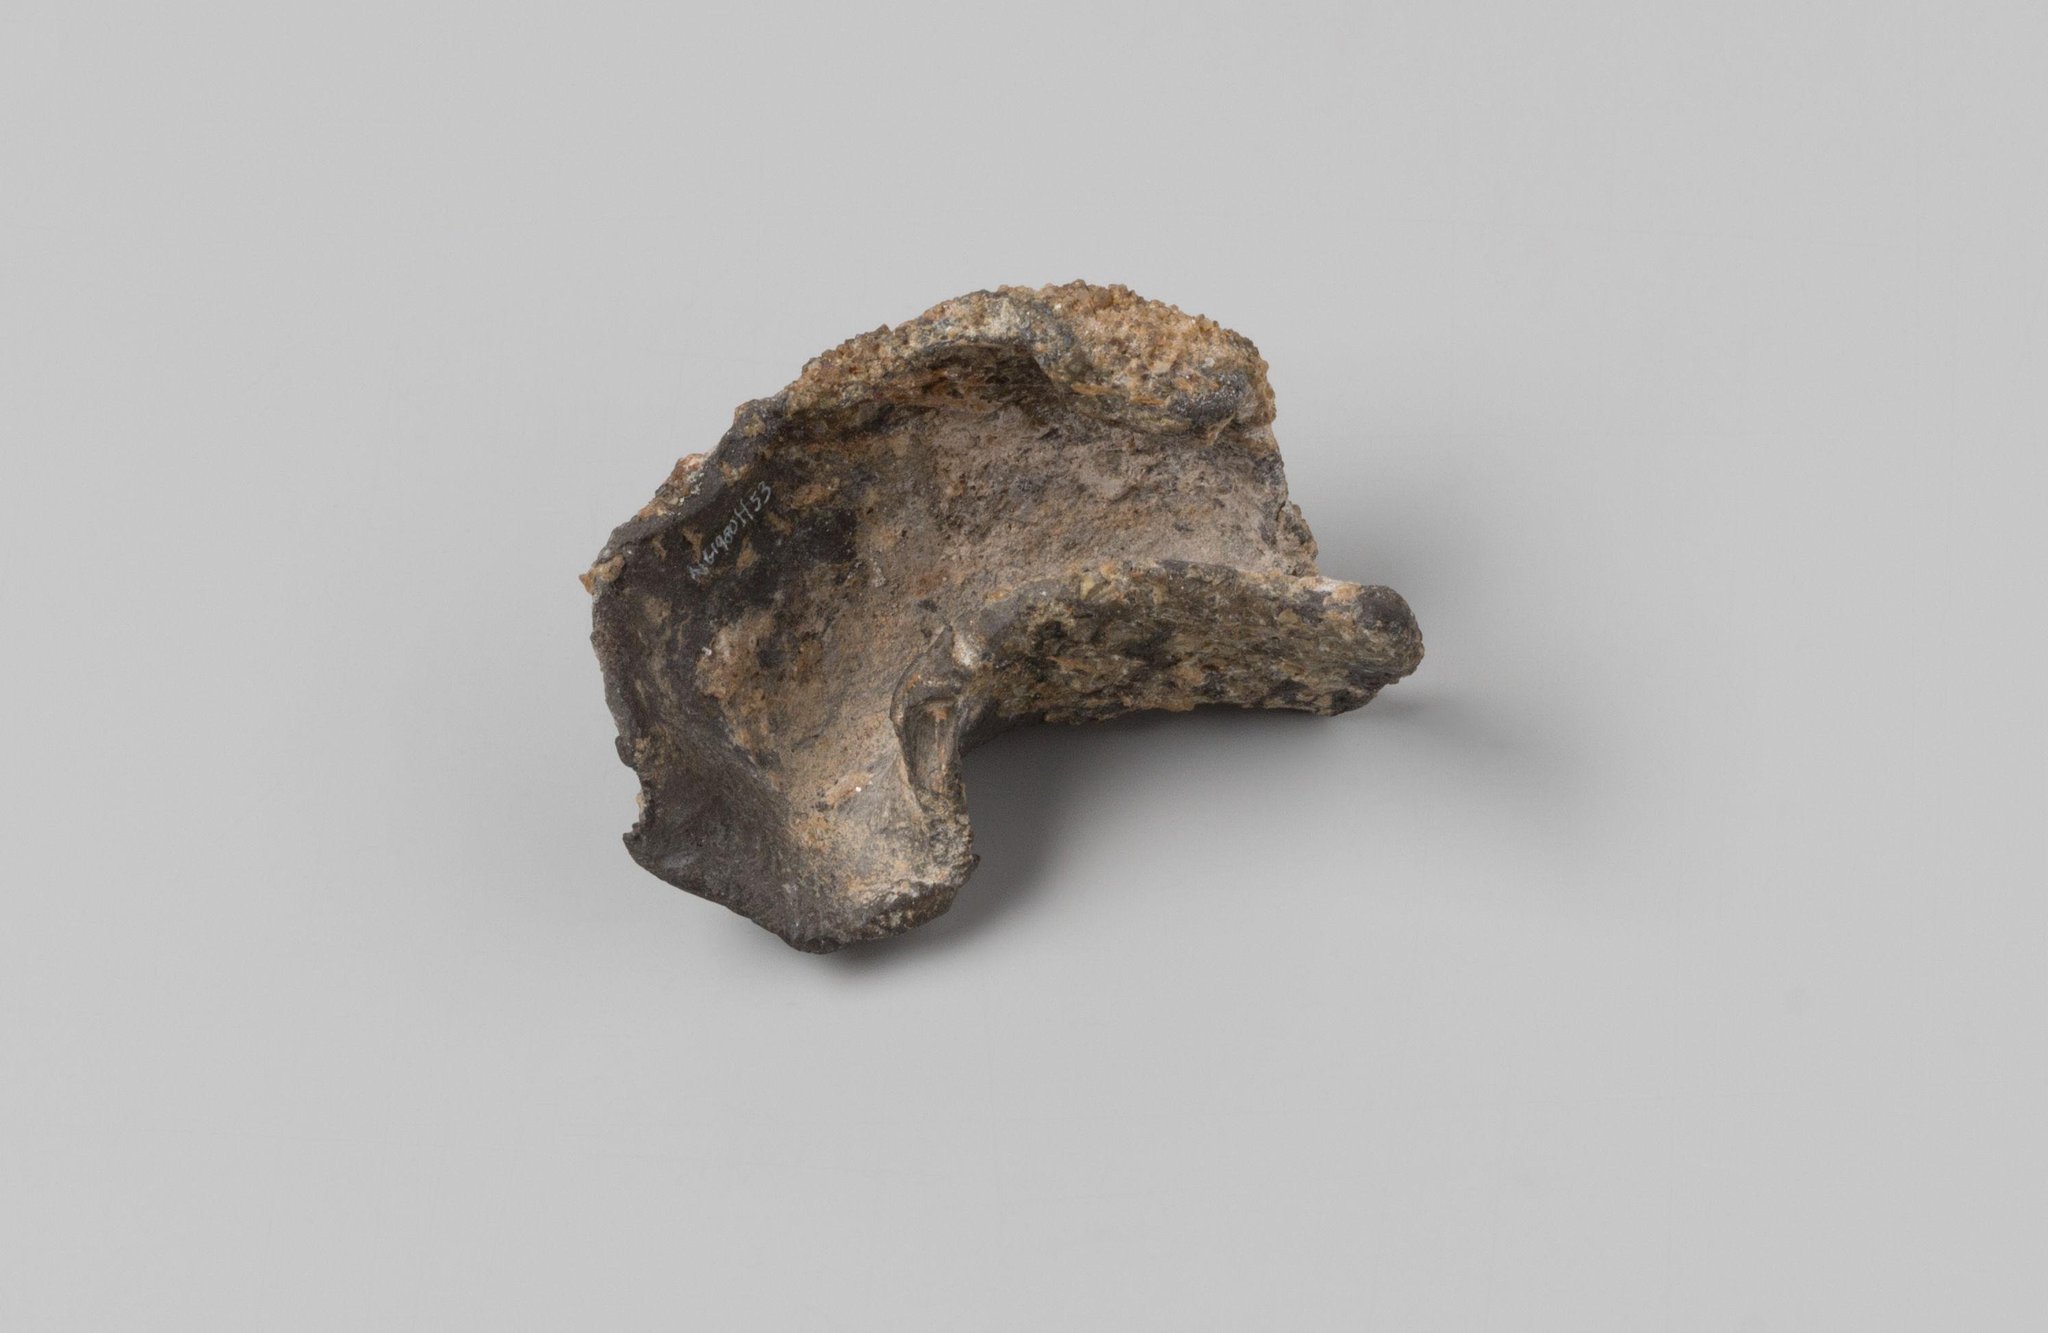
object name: fragment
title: Fragment lood en gruis uit het wrak van de Oost-Indiëvaarder Hollandia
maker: Anonymous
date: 1700-1743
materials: lead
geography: netherlands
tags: verenigde oostindische compagnie, hollandia (schip), annet